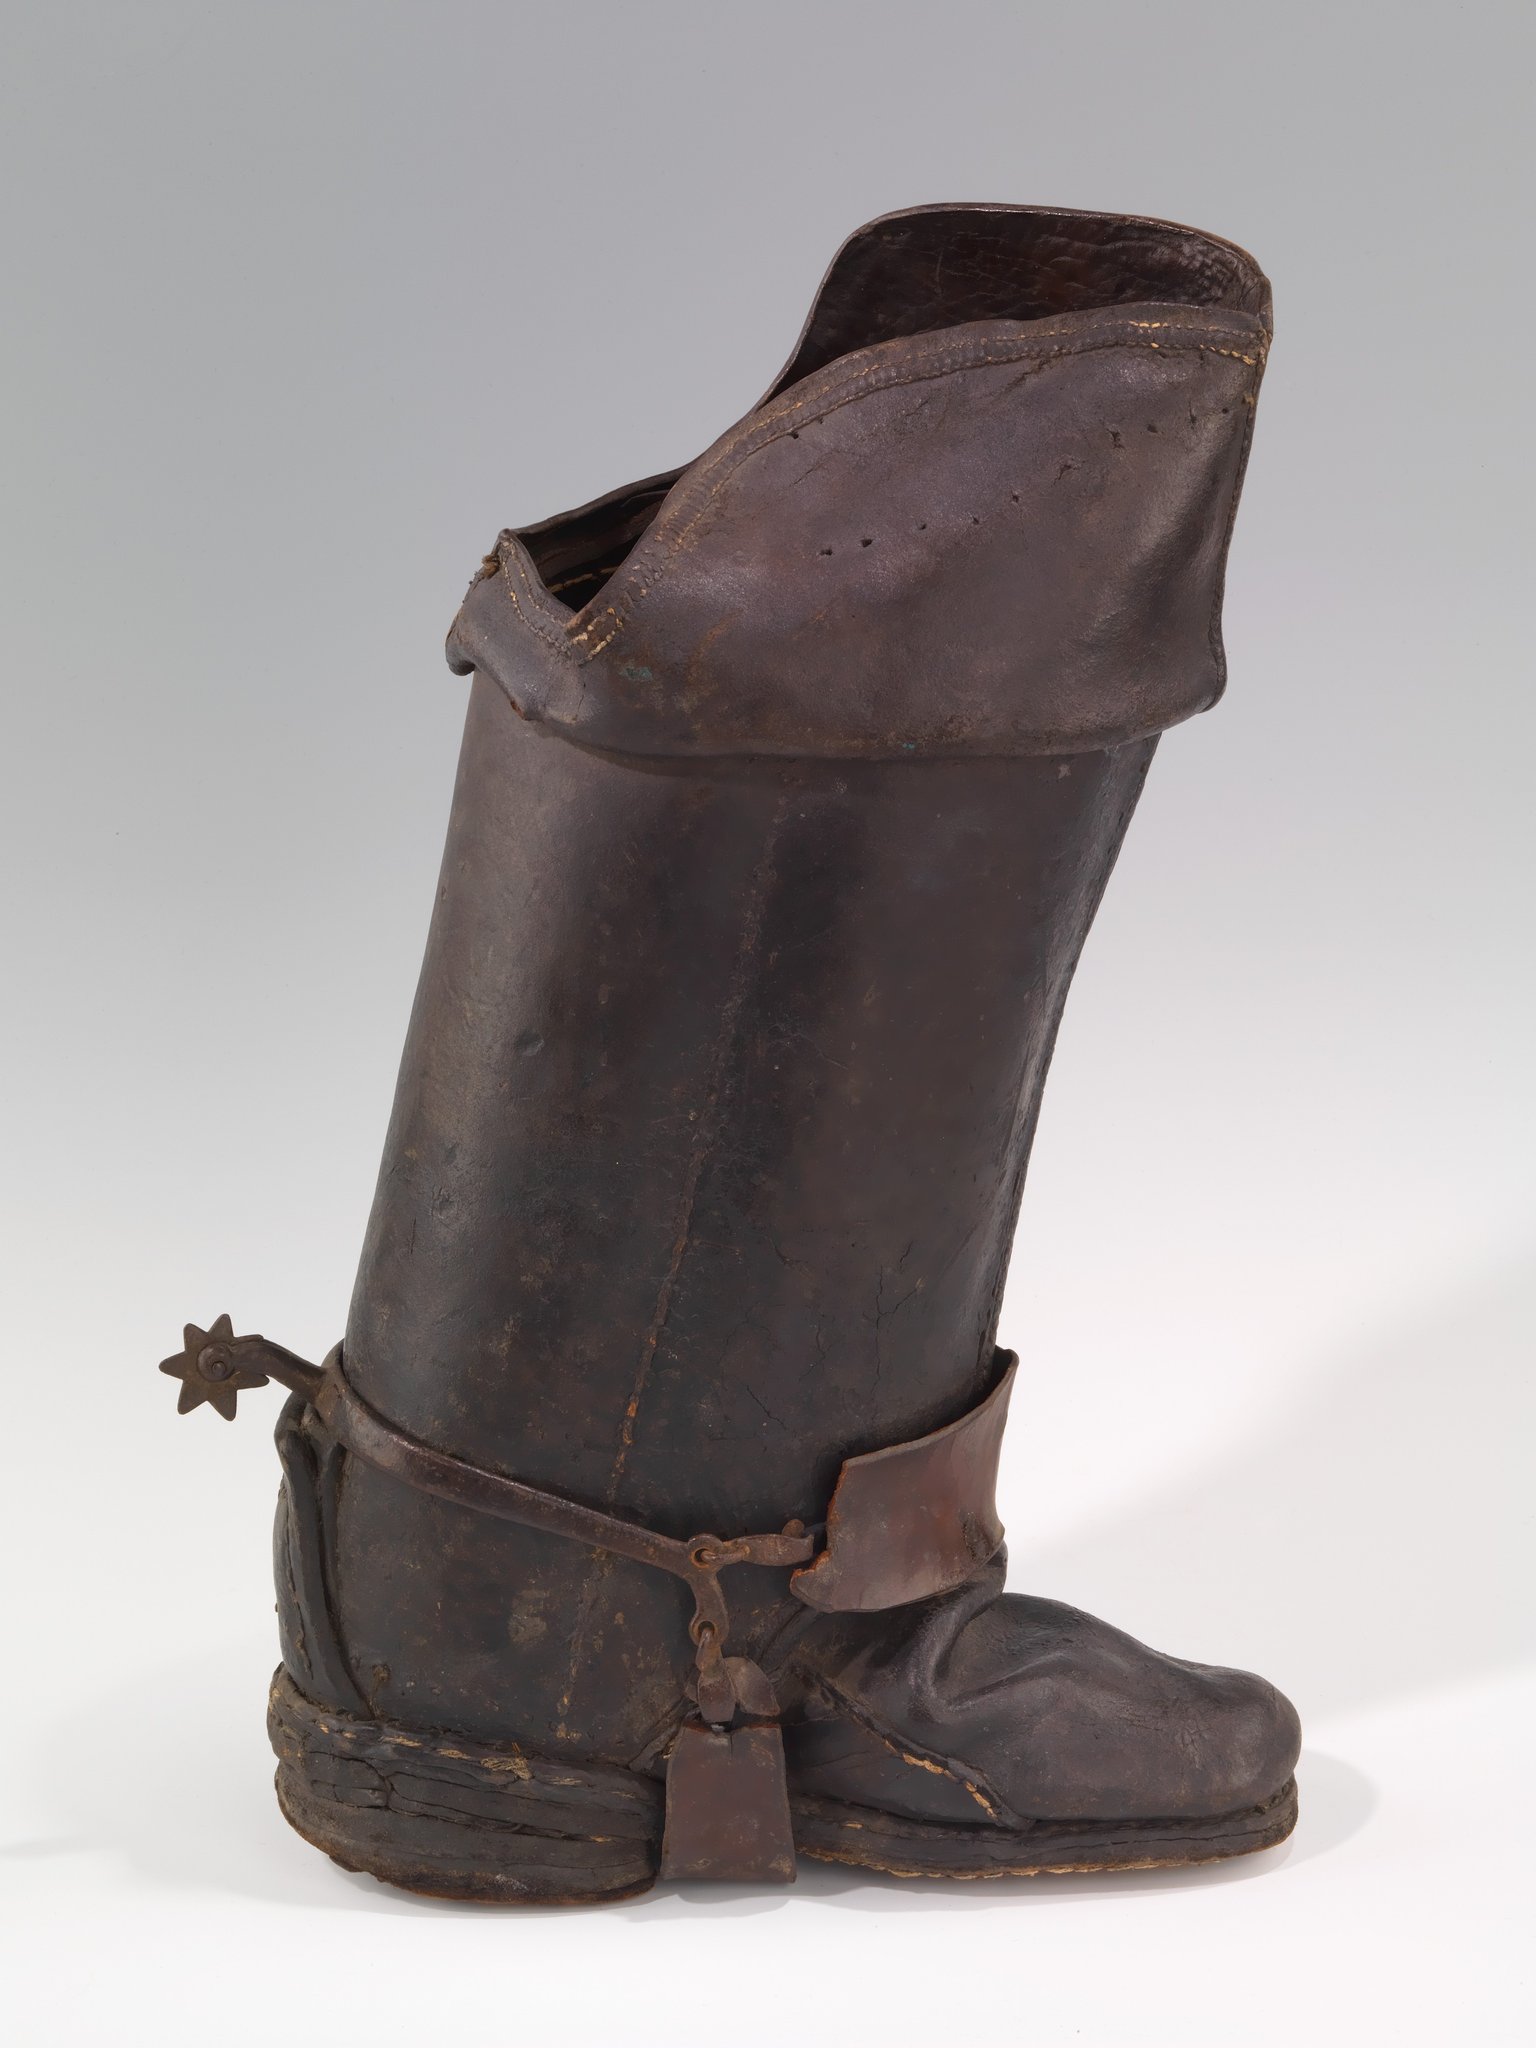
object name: jackboot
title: Jackboots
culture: british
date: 1701-1800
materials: leather